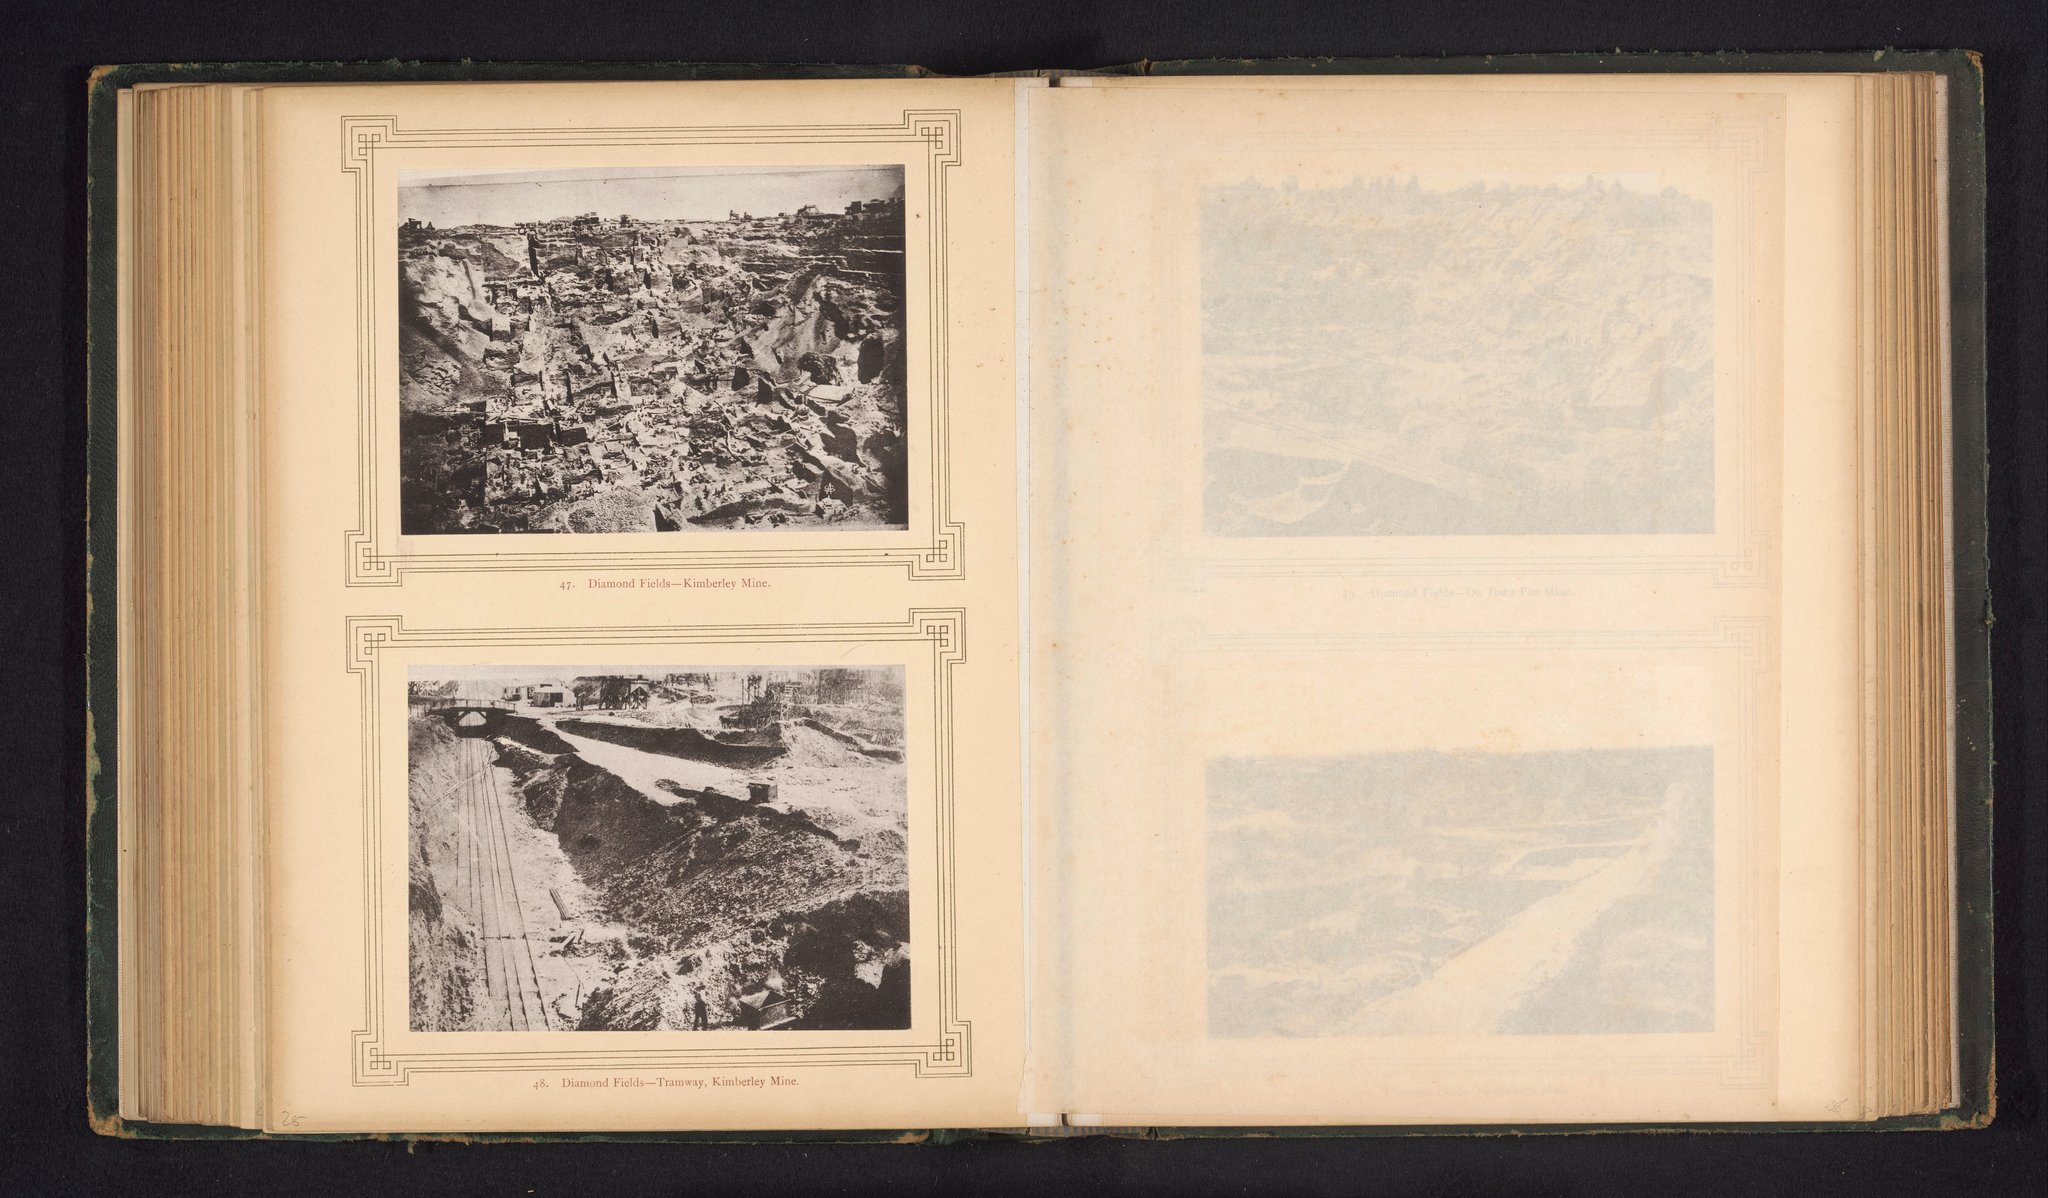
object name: page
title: Diamond fields-Tramway, Kimberley mine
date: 1870-1880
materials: paper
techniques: photograph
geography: die groot gat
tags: tramway, tram, quarry, mine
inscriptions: inscription: ‘SA’, number: ‘47. 48.’